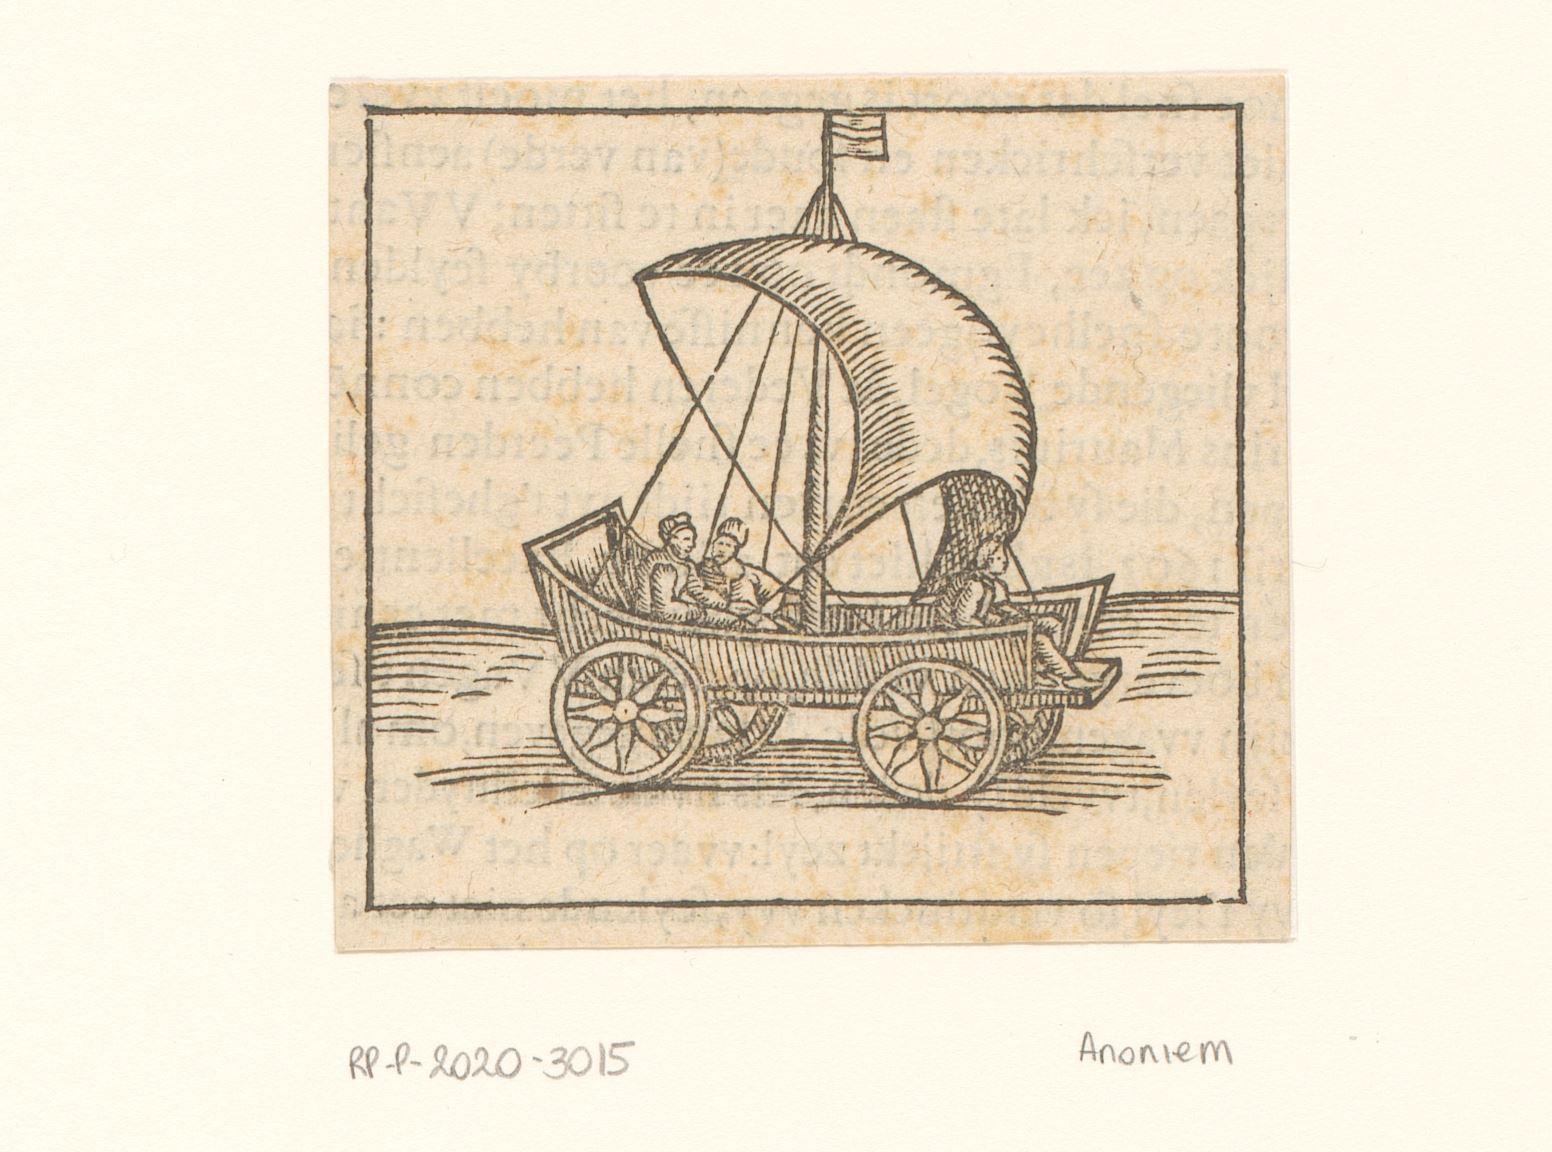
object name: print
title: Zeilwagen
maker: Anonymous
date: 1607-1650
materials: paper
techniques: letterpress printing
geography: northern netherlands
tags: sailing-car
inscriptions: collector's mark: Lugt 240, collector's mark: Lugt 698